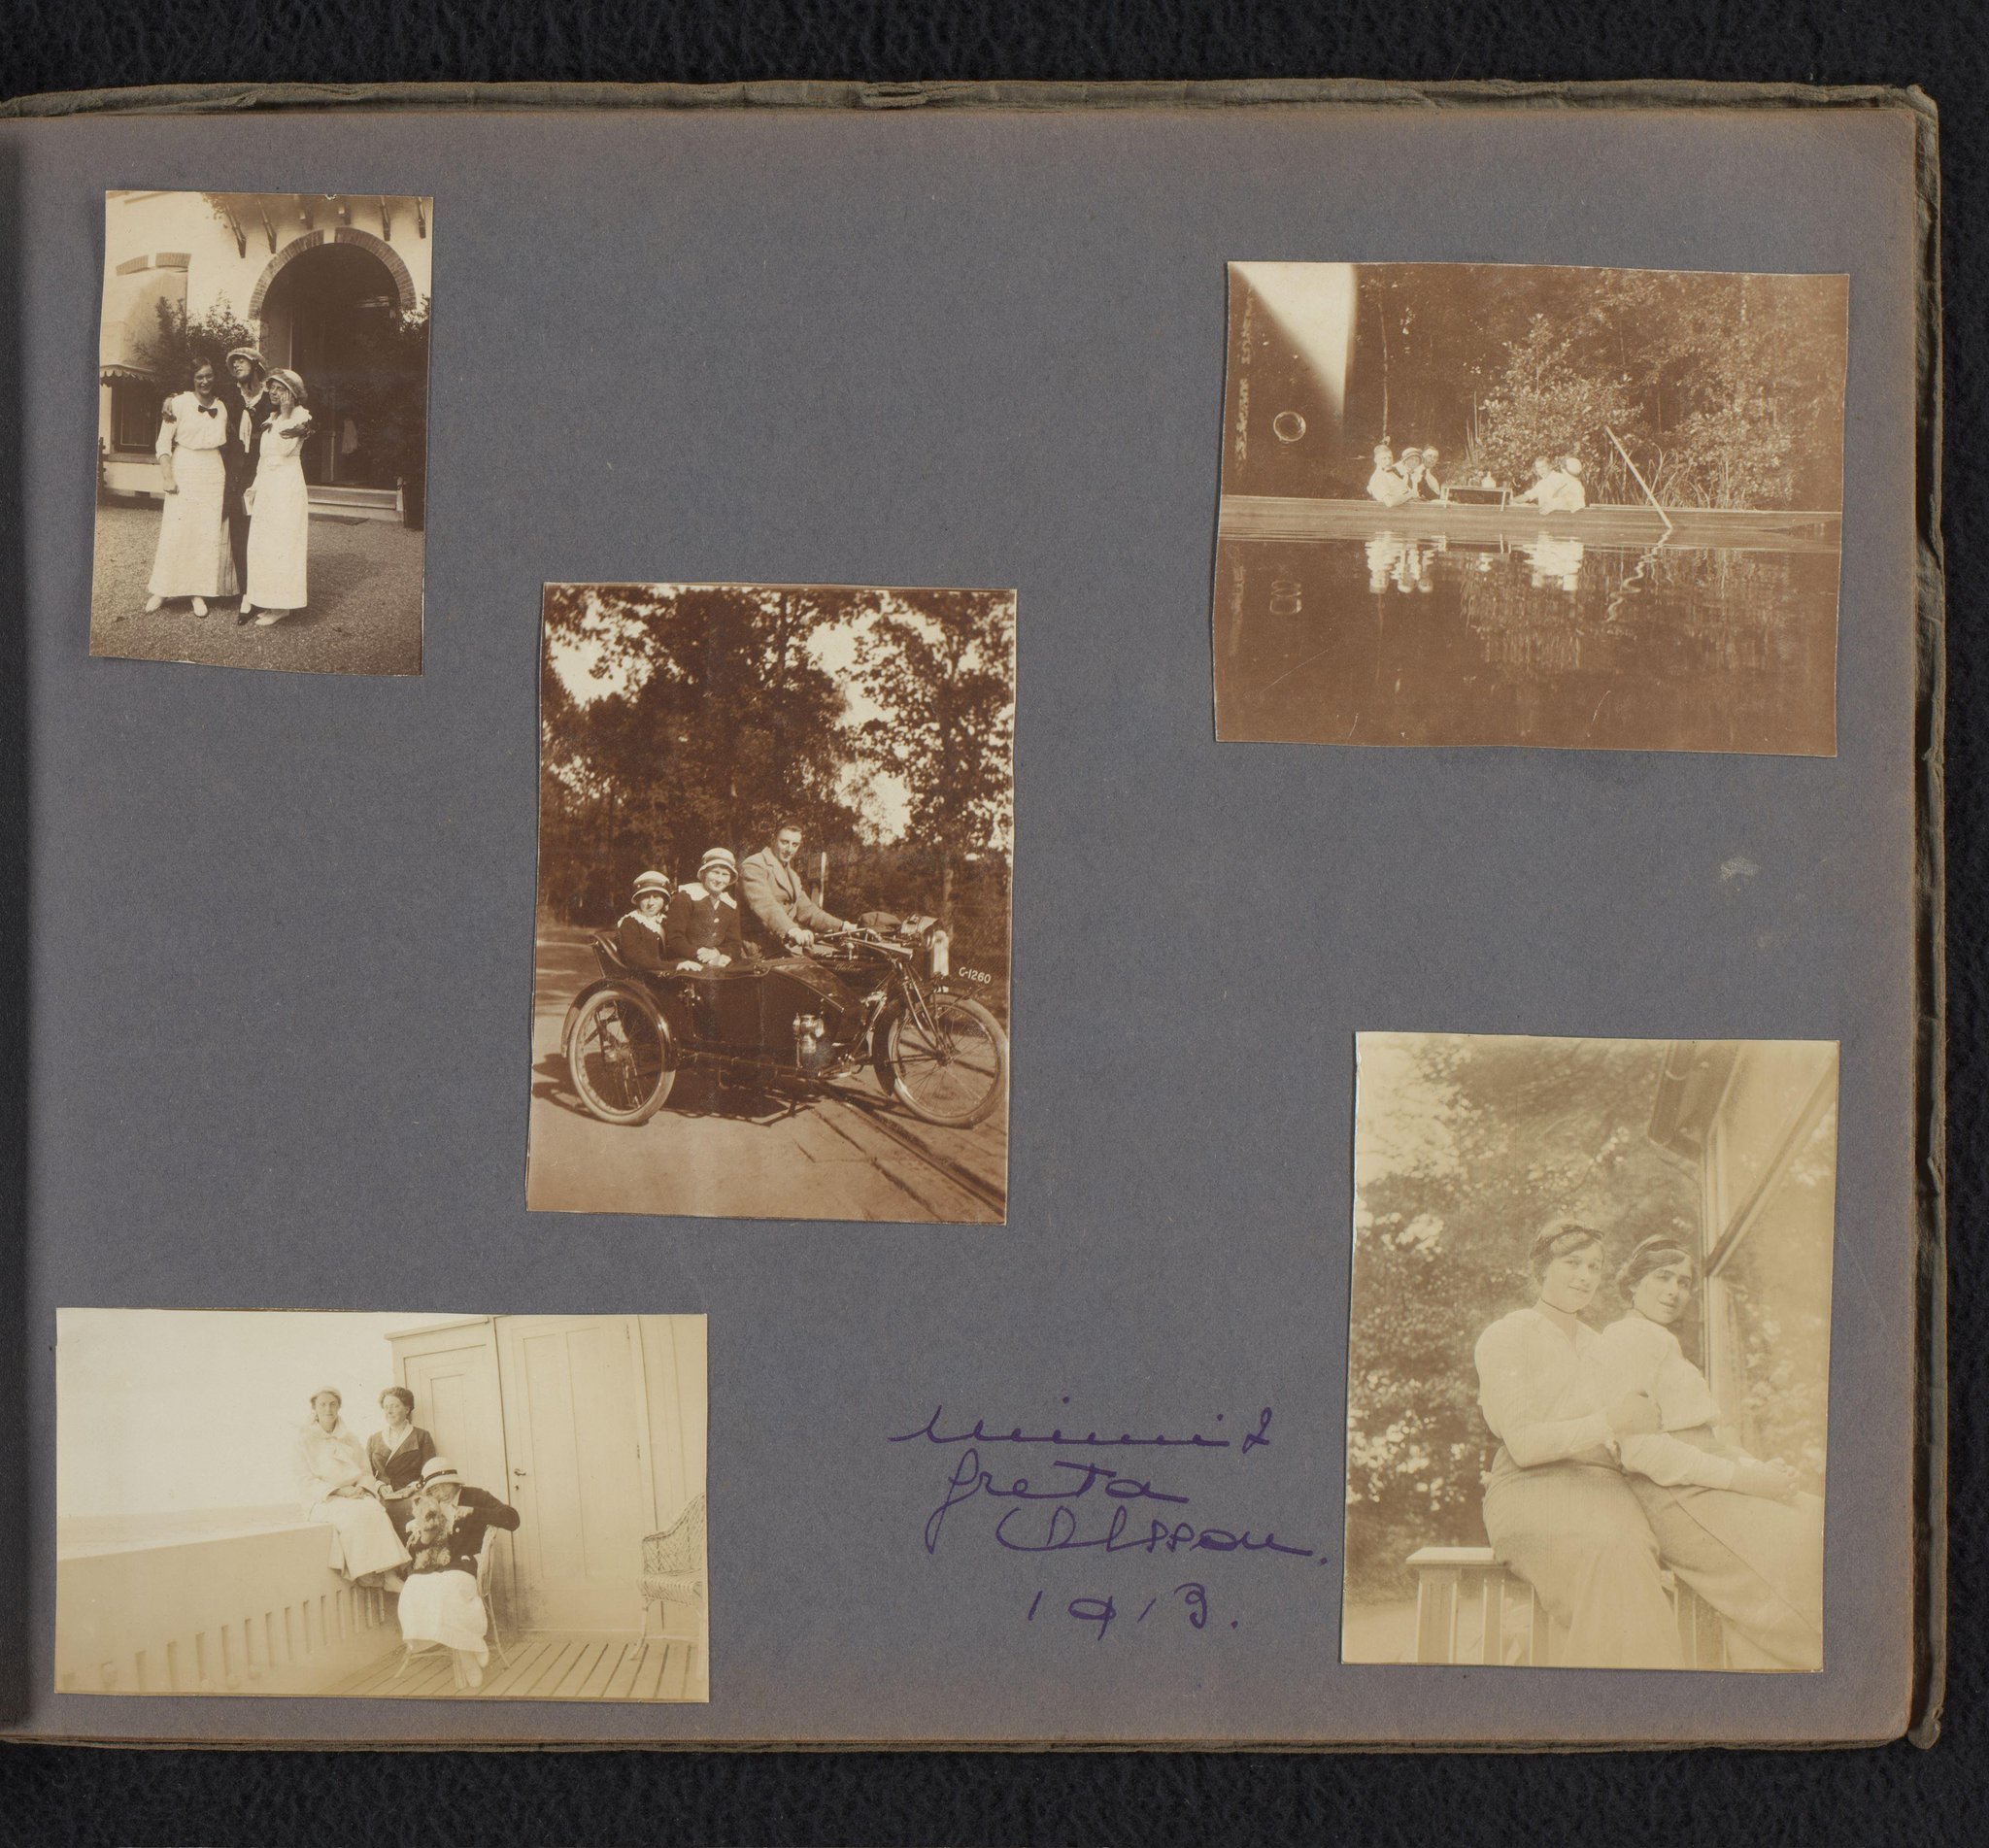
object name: photograph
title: Vriendengroep op een boot, een motorfiets en in een tuin, met Winnie en Greta Olsson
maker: Anonymous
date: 1913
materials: paper, cardboard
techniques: gelatin silver print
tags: historical persons - bb - woman, motor-cycles and other two-wheeled motor-vehicles, ships (in general), anonymous historical person portrayed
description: Deze foto's zijn onderdeel van een album.